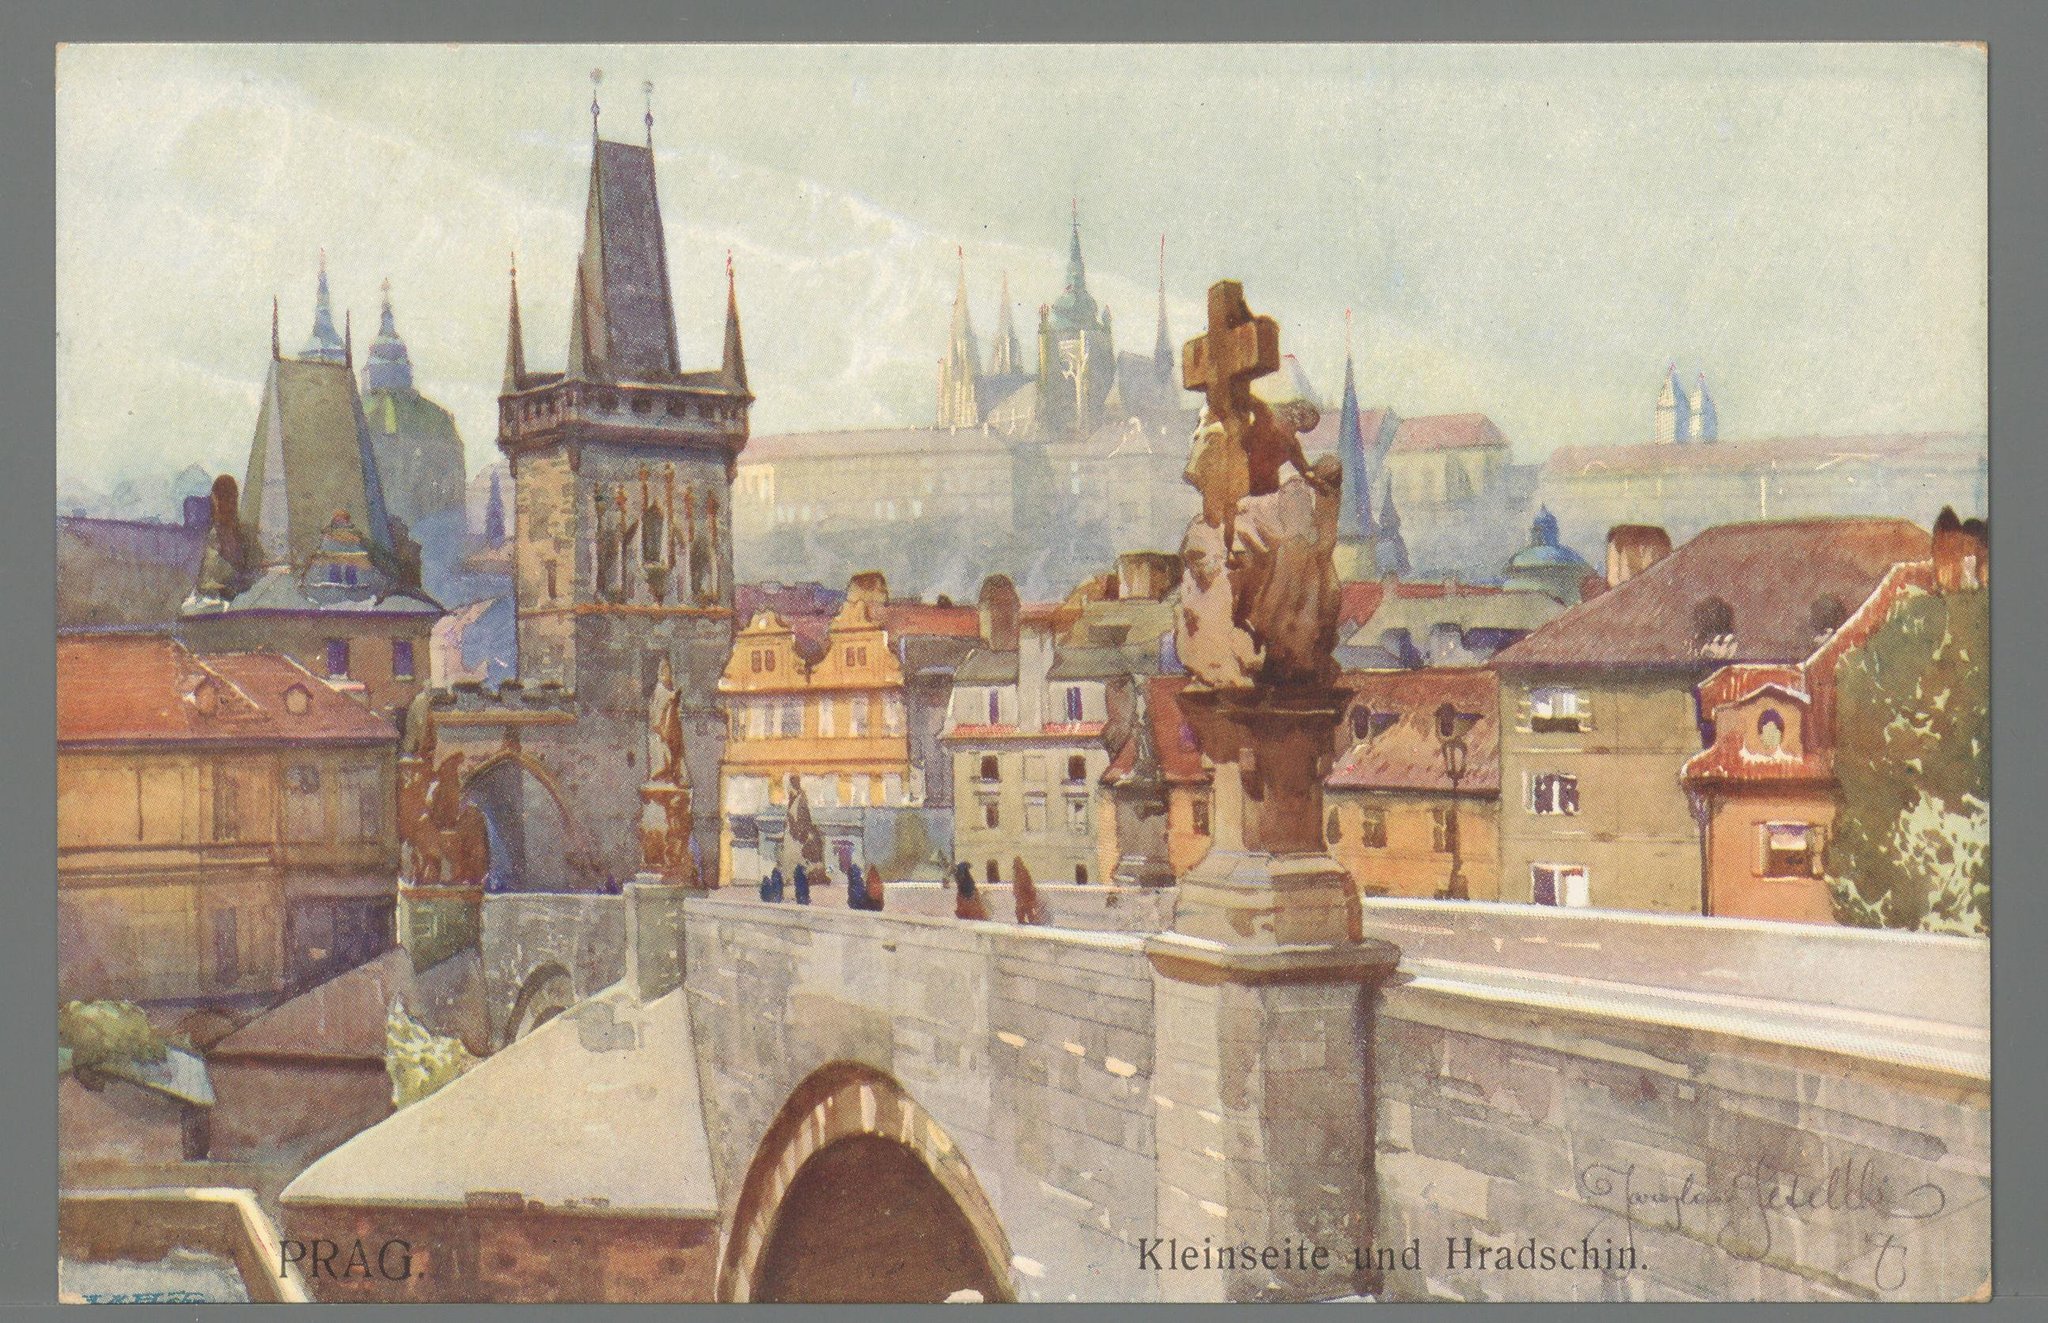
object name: ansichtkaart, prentbriefkaart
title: Prag. Kleinseite und Hradschin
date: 1906-1930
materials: cardboard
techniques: color autotype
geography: prague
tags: castle, church (exterior), bridge in city across river, canal, etc., city-gate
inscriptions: inscription: ‘H&H’